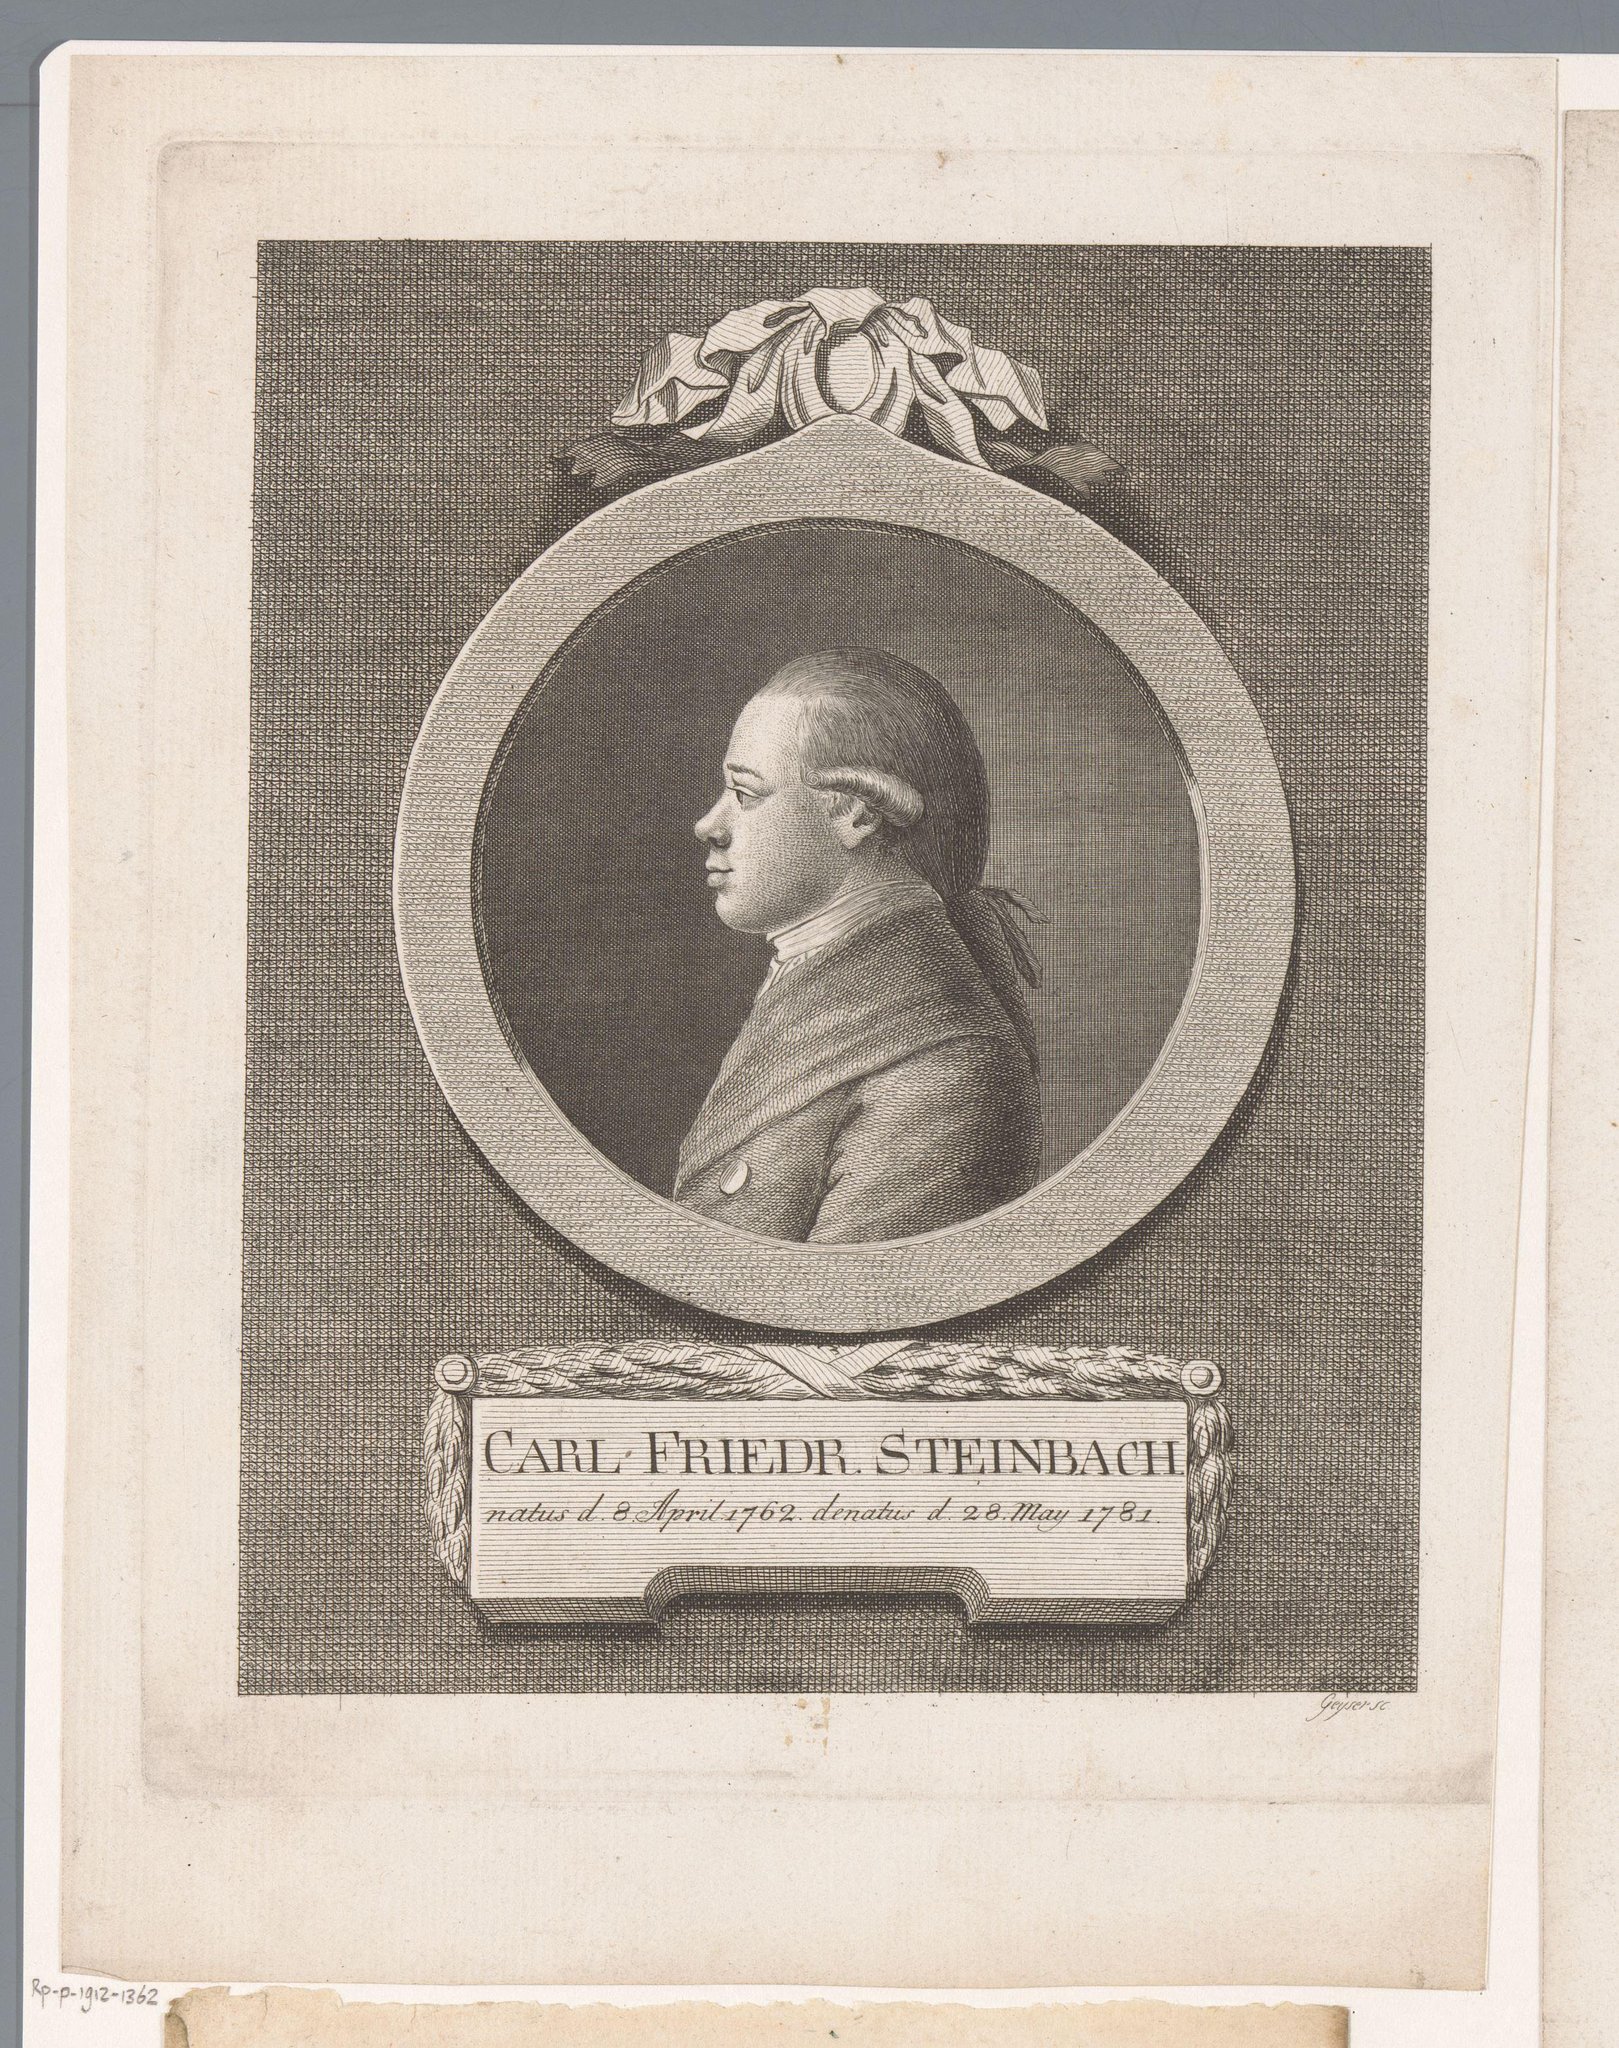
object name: print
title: Portret van Carl Friedrich Steinbach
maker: christian gottlieb geyser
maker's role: print maker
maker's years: 1742-1803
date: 1781-1803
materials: paper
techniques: engraving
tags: historical persons, ornament ~ festoon, garland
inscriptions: collector's mark: Lugt 2228